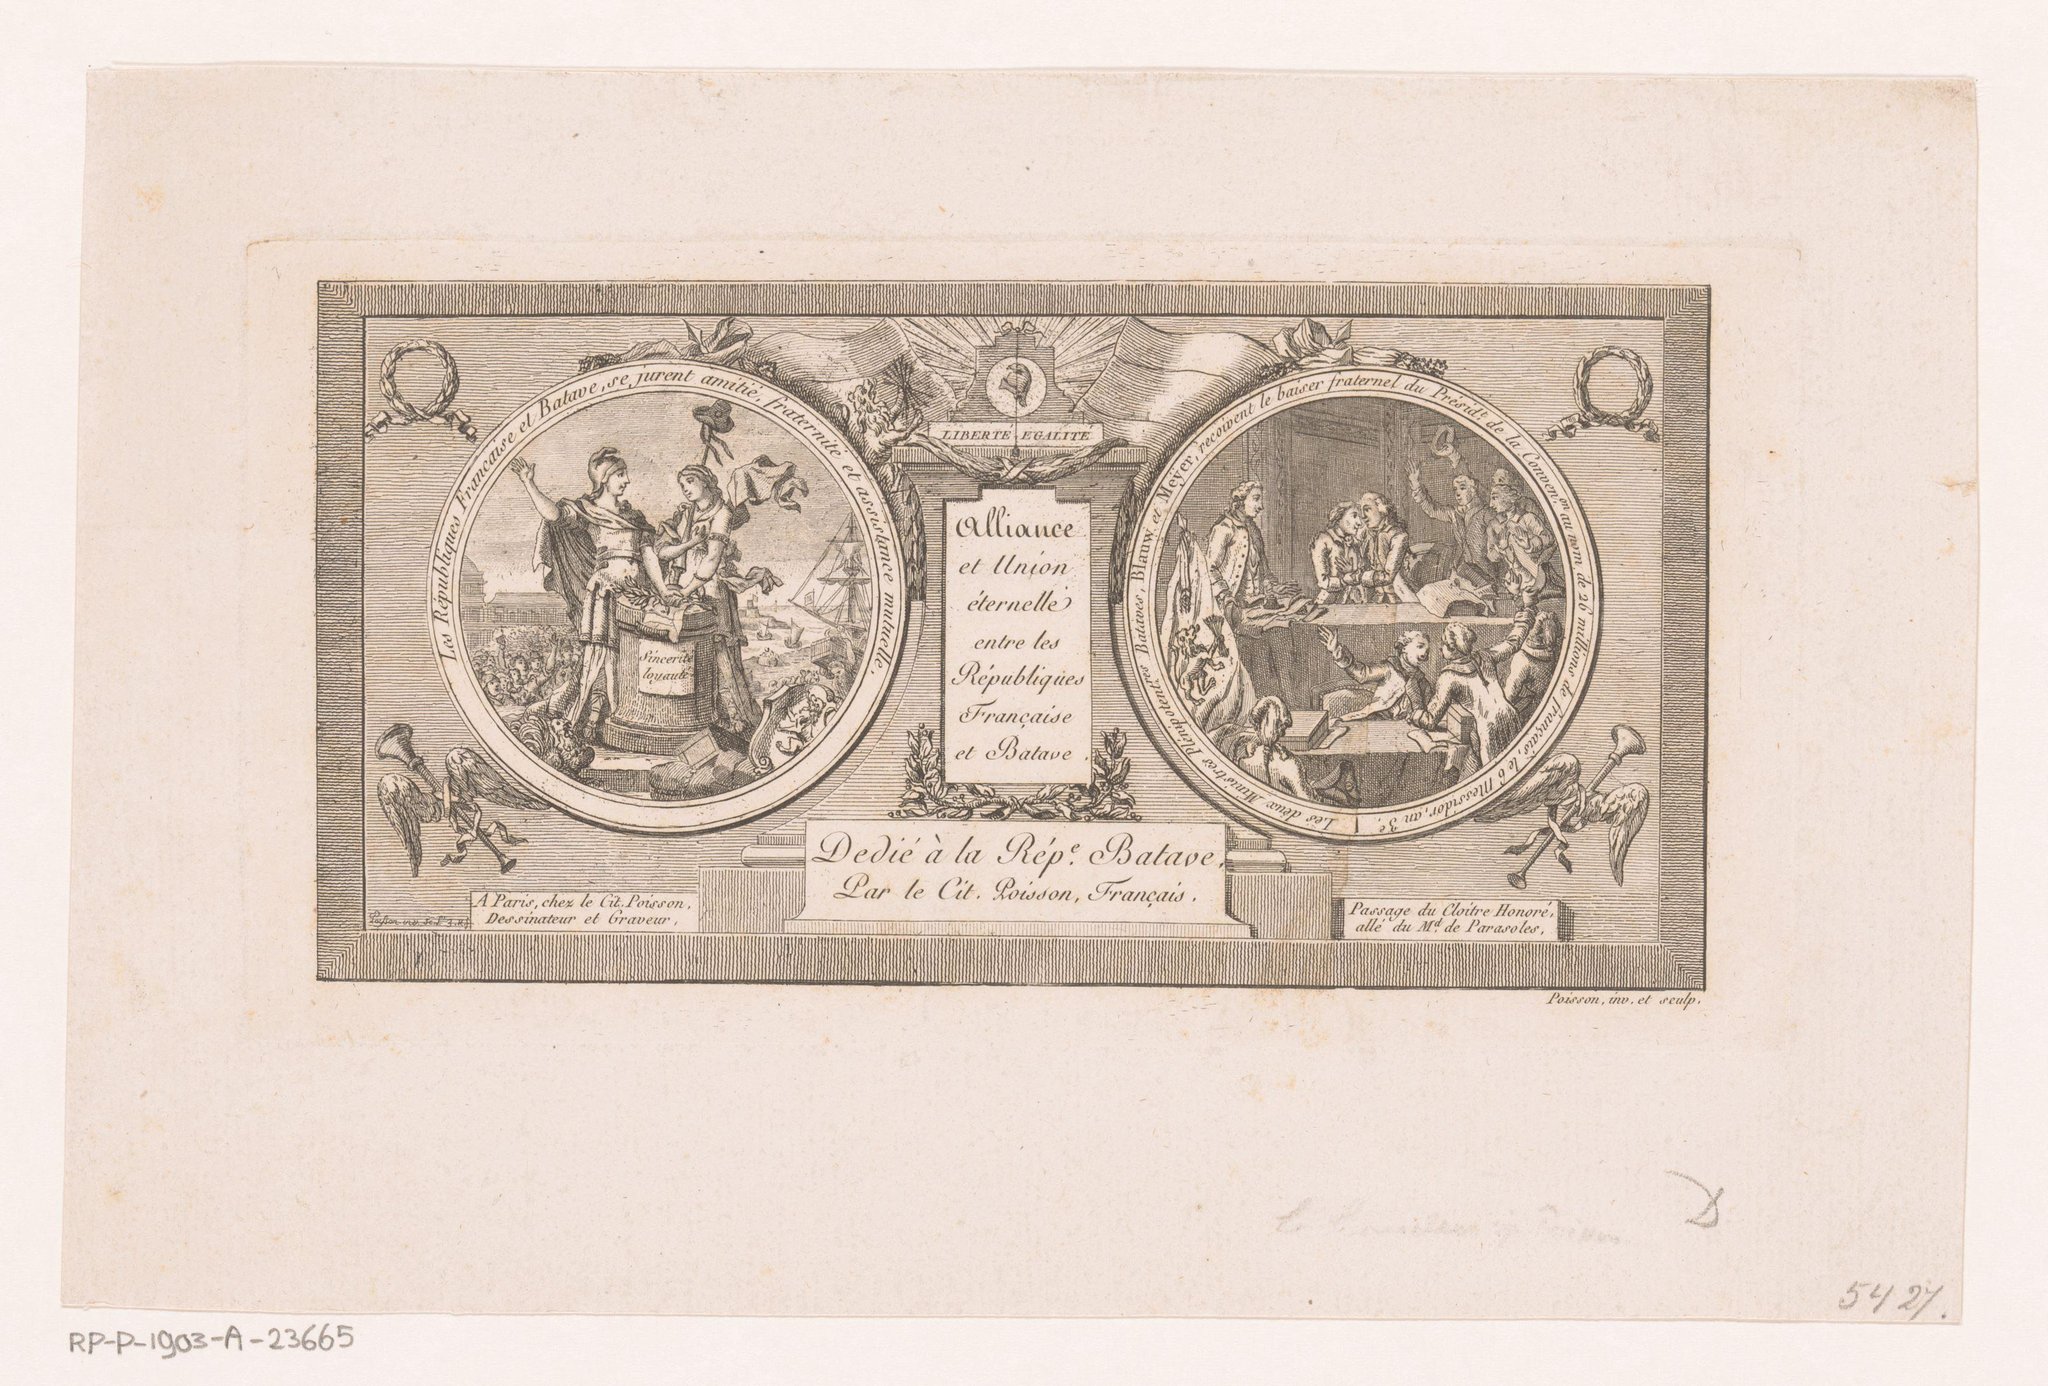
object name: print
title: Alliance et Union éternelle entre les Républiques Française et Batave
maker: michel poisson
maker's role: print maker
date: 1795-1801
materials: paper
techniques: etching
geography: paris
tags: republic; 'governo della republica' (ripa), personifications of countries, nations, states, districts, etc.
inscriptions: collector's mark: Lugt 2228